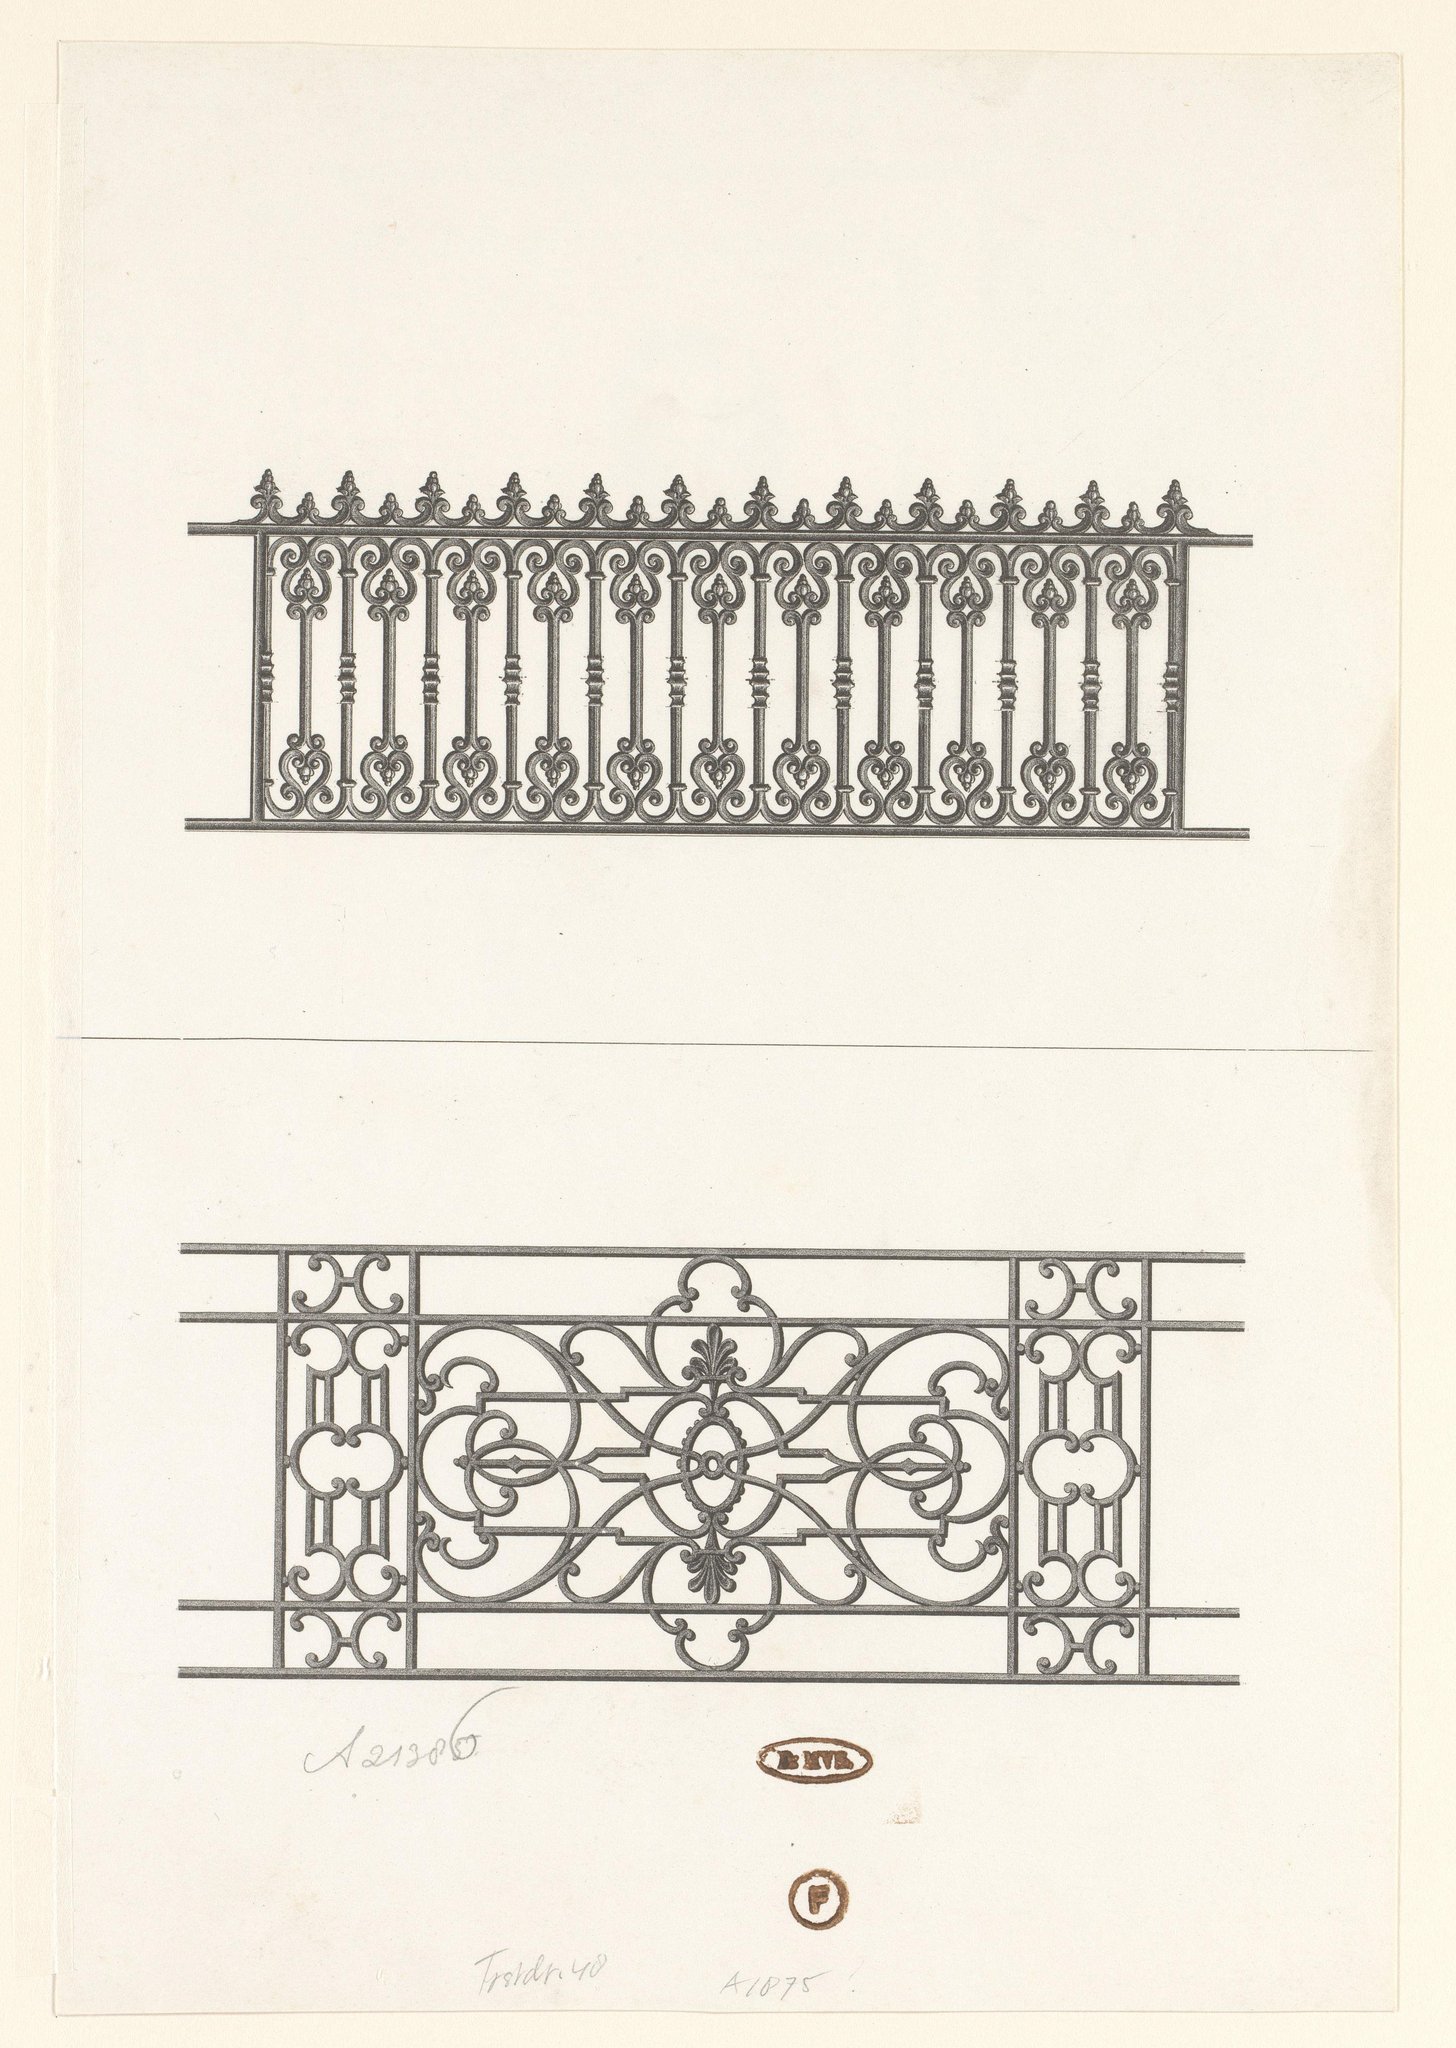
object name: print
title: Twee ontwerpen voor decoratief hekwerk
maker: Anonymous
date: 1857-1858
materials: paper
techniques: lithograph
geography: paris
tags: ornaments ~ art, fence, wall, paling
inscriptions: collector's mark: Lugt 964